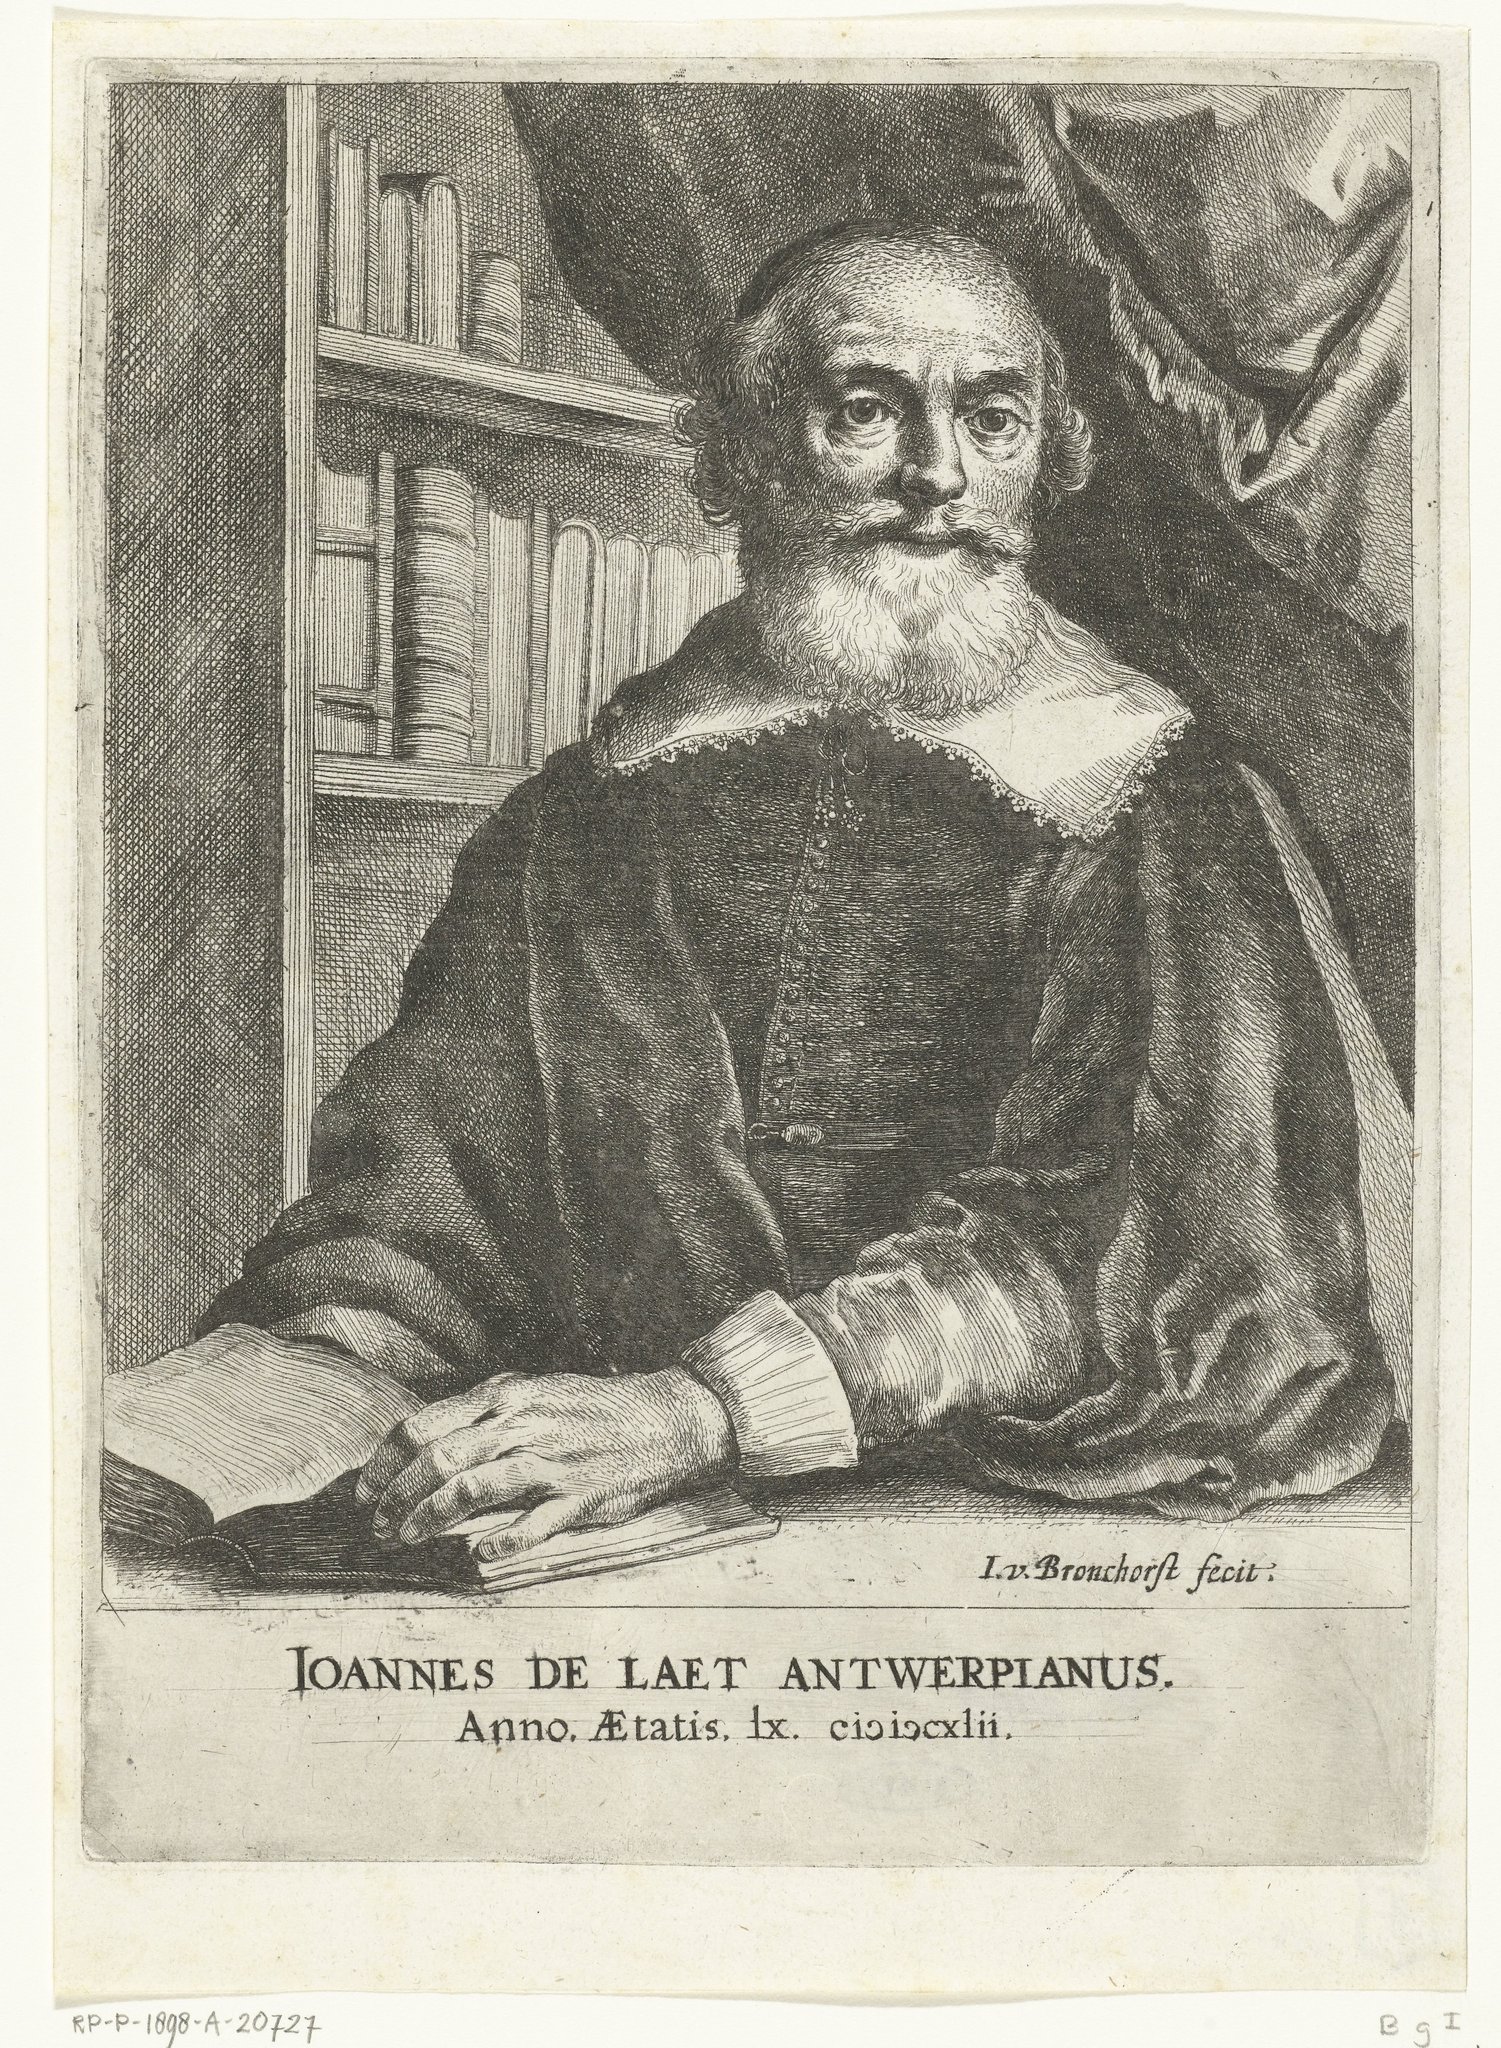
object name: print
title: Portret van Johannes de Laet op zestig jarige leeftijd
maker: jan gerritsz. van bronckhorst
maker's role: draughtsman, painter, print maker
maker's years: 1603-1661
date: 1641-1661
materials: paper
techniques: etching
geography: netherlands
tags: antwerp, leiden, johannes de laet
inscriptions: collector's mark: Lugt 963, collector's mark: Lugt 2228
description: Portret van Johannes de Laet, op zestigjarige leeftijd met opengeslagen boek.